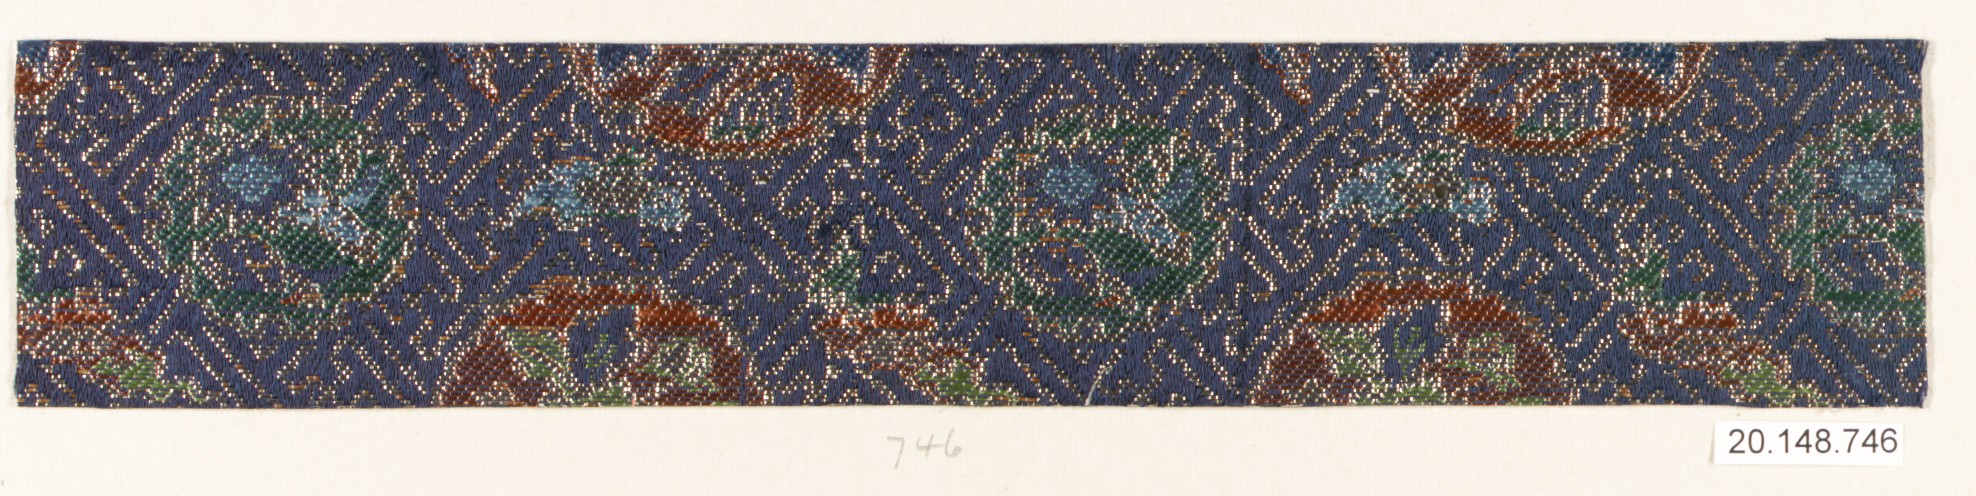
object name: piece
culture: japanese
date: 1601-1700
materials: silk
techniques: compound weave